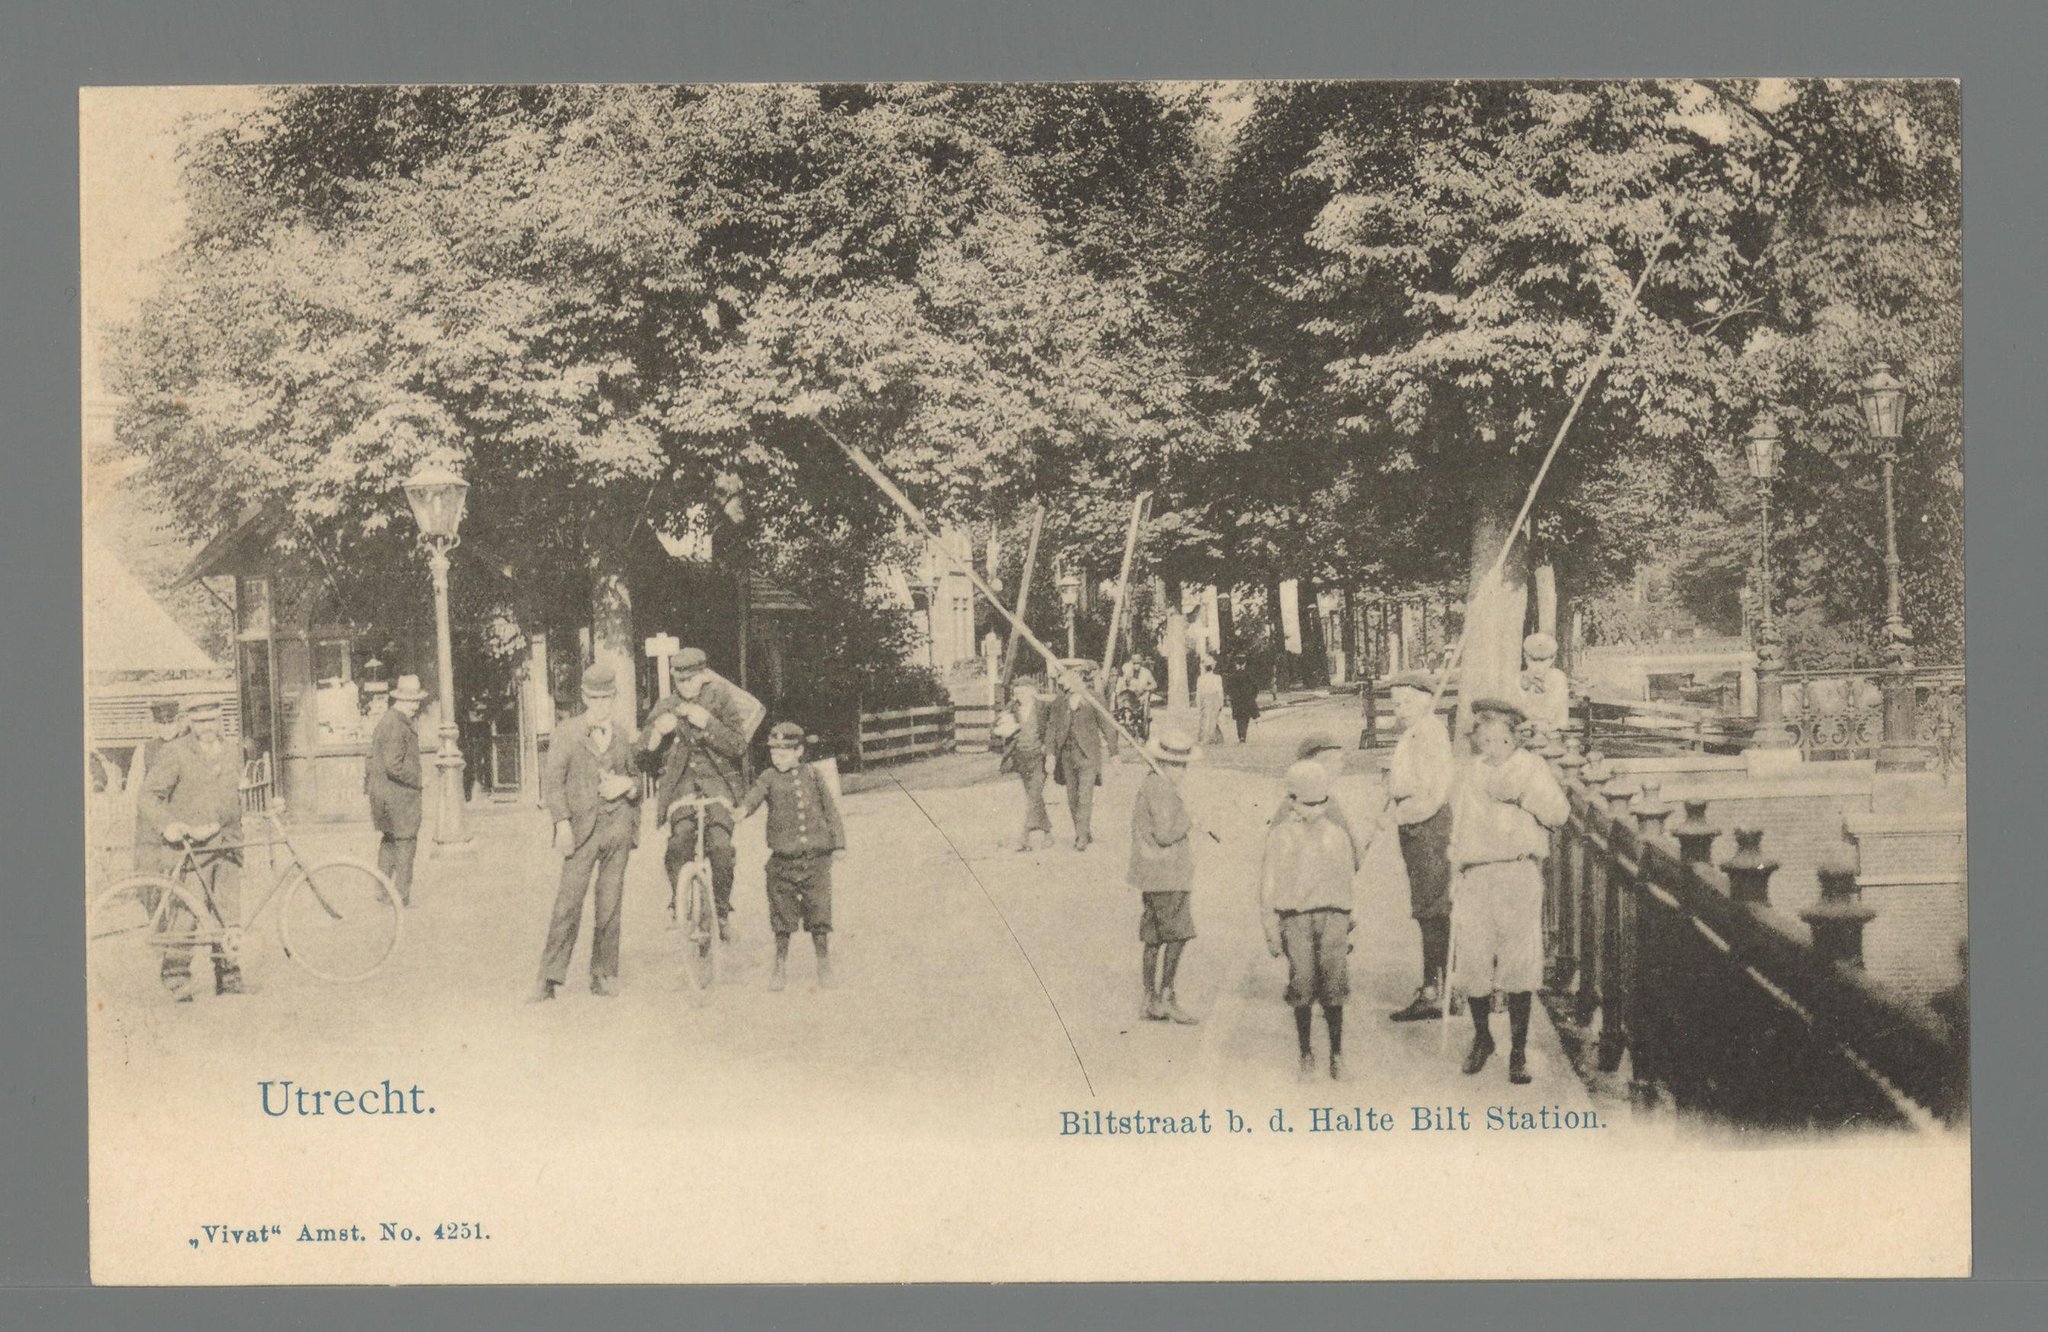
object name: ansichtkaart, prentbriefkaart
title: Utrecht. Biltstraat b. d. Halte Bilt Station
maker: Anonymous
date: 1897-1905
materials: cardboard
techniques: photograph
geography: utrecht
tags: station; shelter (railway, tramway), street